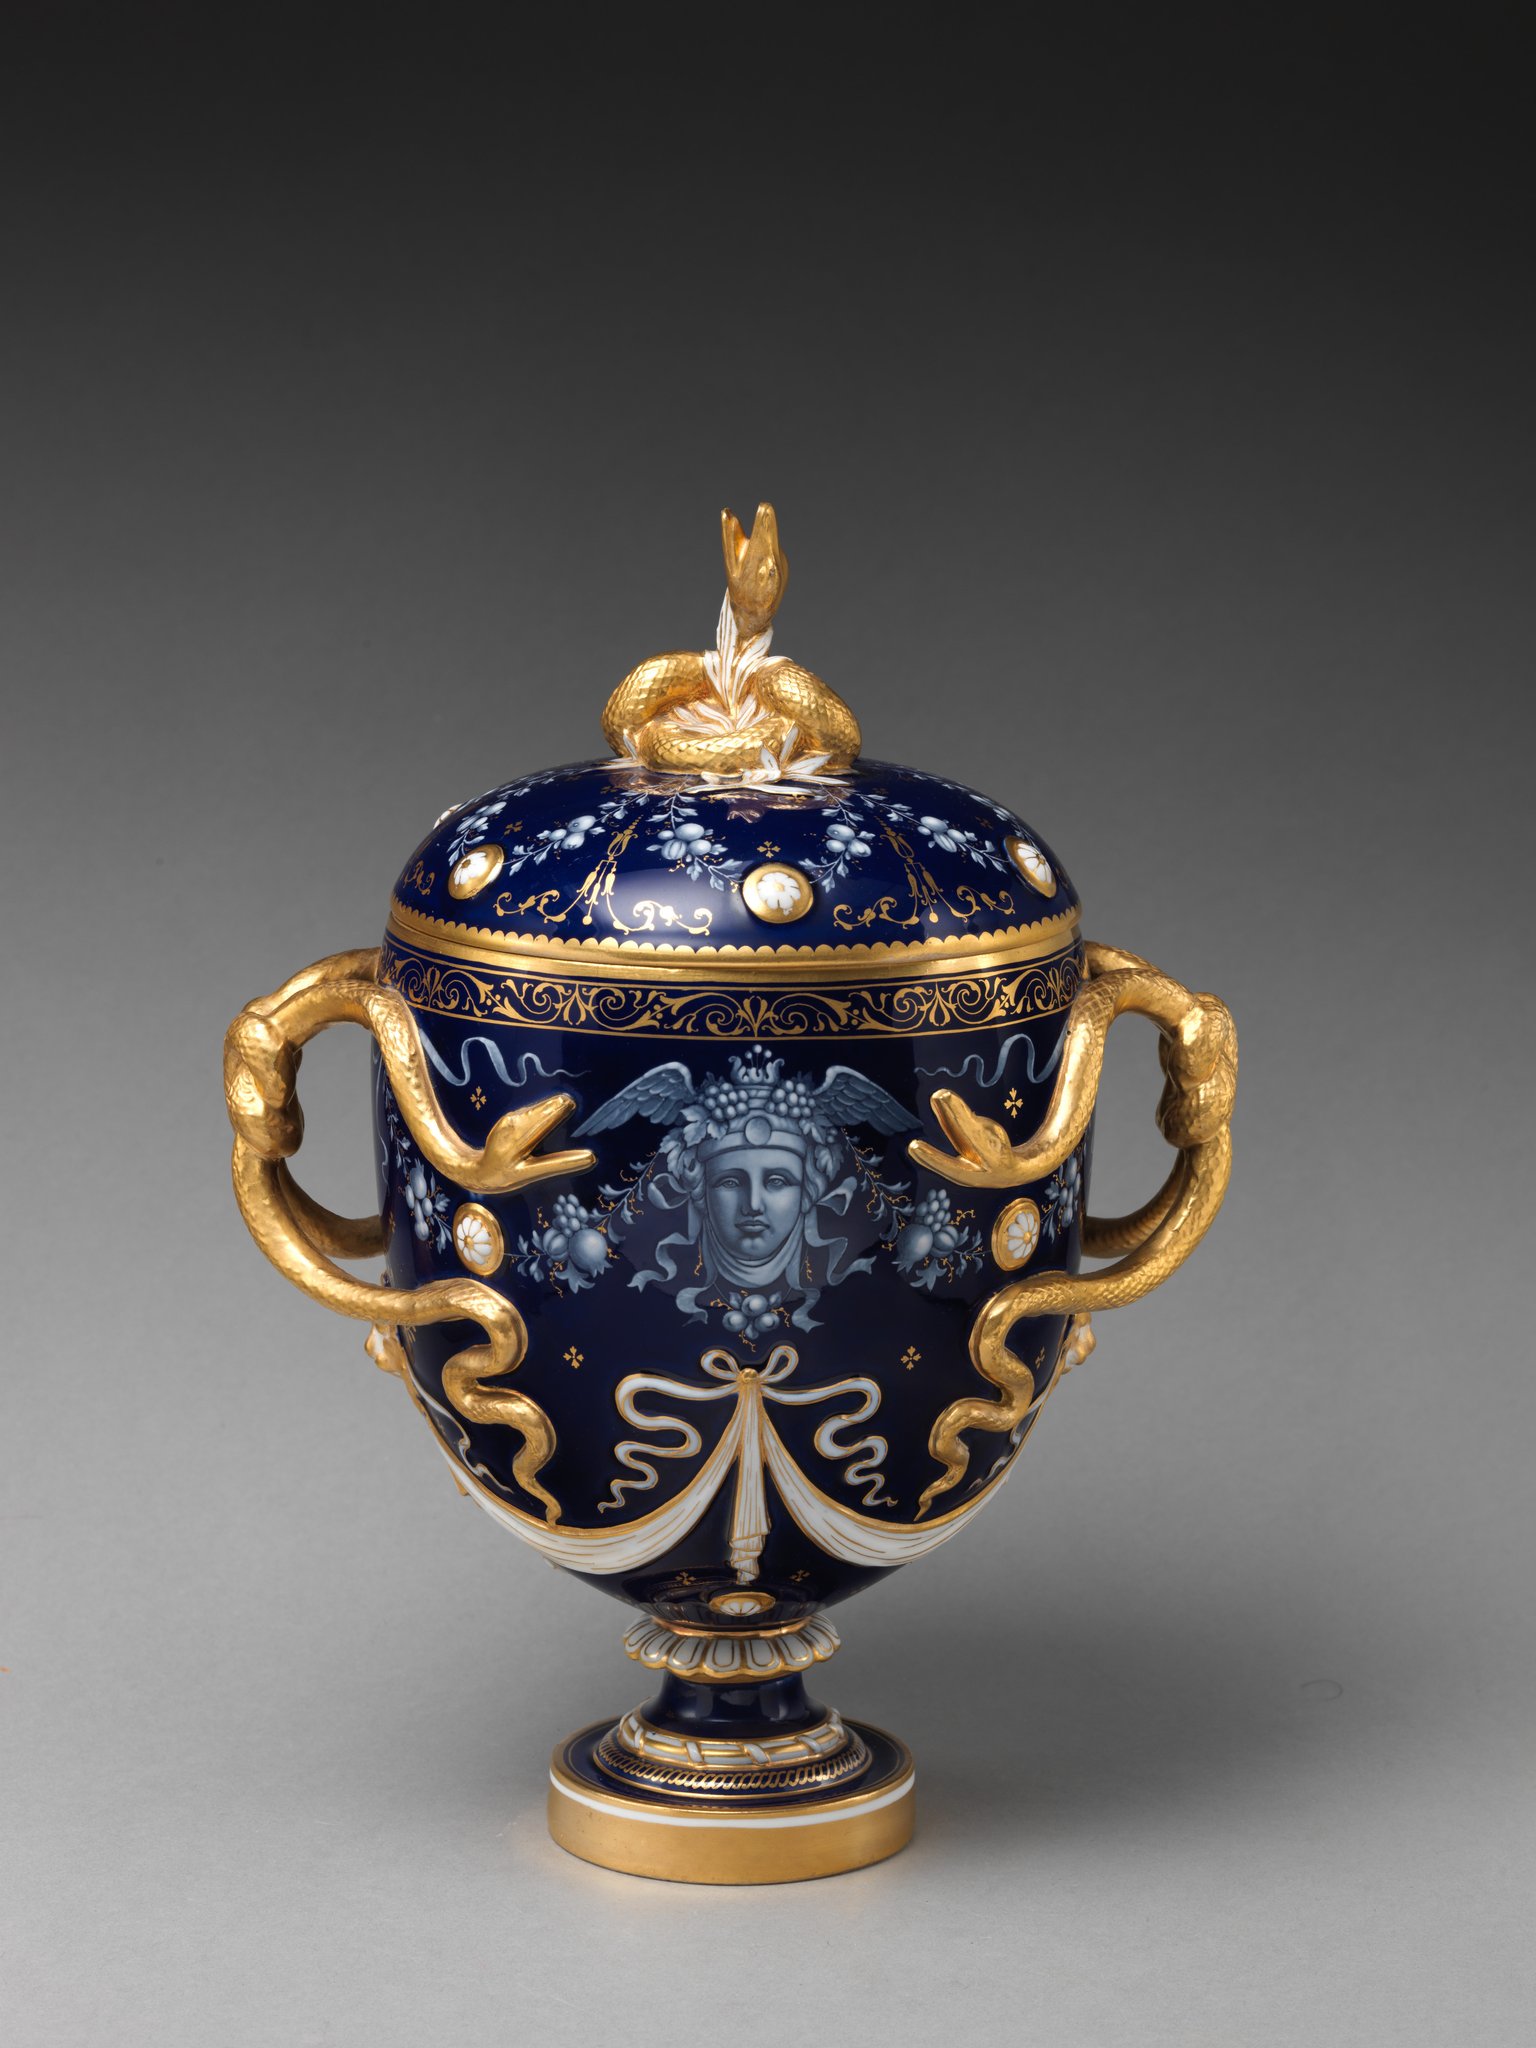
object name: lidded vase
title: Lidded vase with Medusa decoration and snake handles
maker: minton(s)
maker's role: maker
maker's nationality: british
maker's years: 1793-2001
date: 1891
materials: bone china